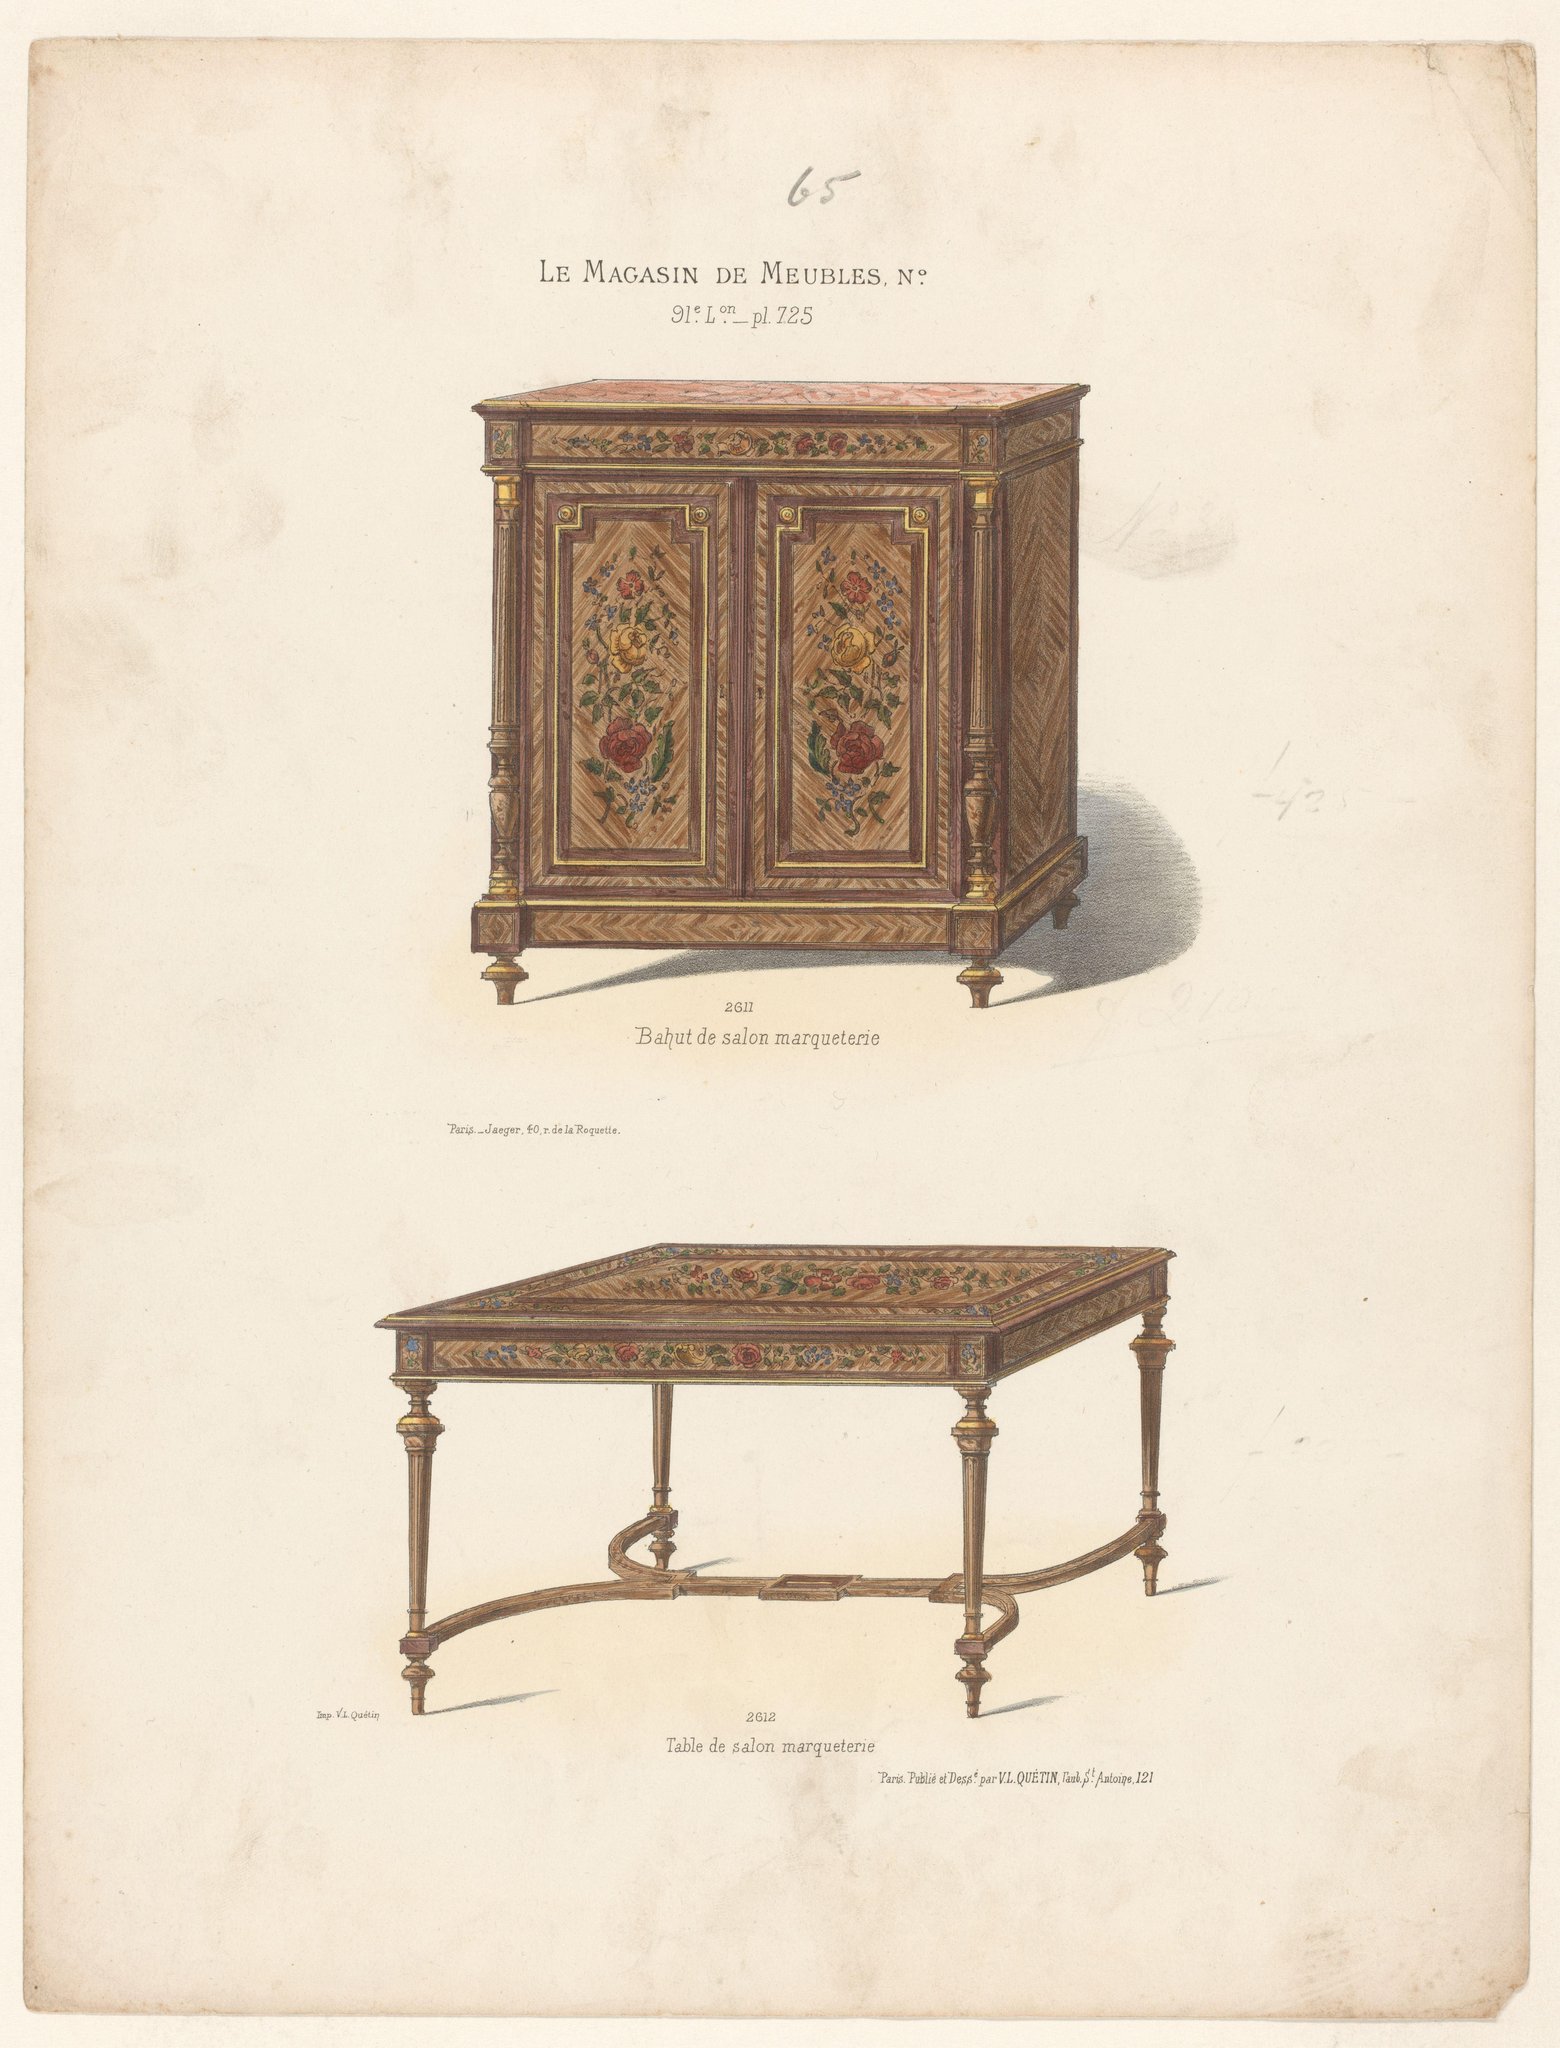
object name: print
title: Kast en tafel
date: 1878-1904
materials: paper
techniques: hand coloring, lithograph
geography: paris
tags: furniture for storage, table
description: Een lage kast en tafel. Prent uit 91e Livraison.